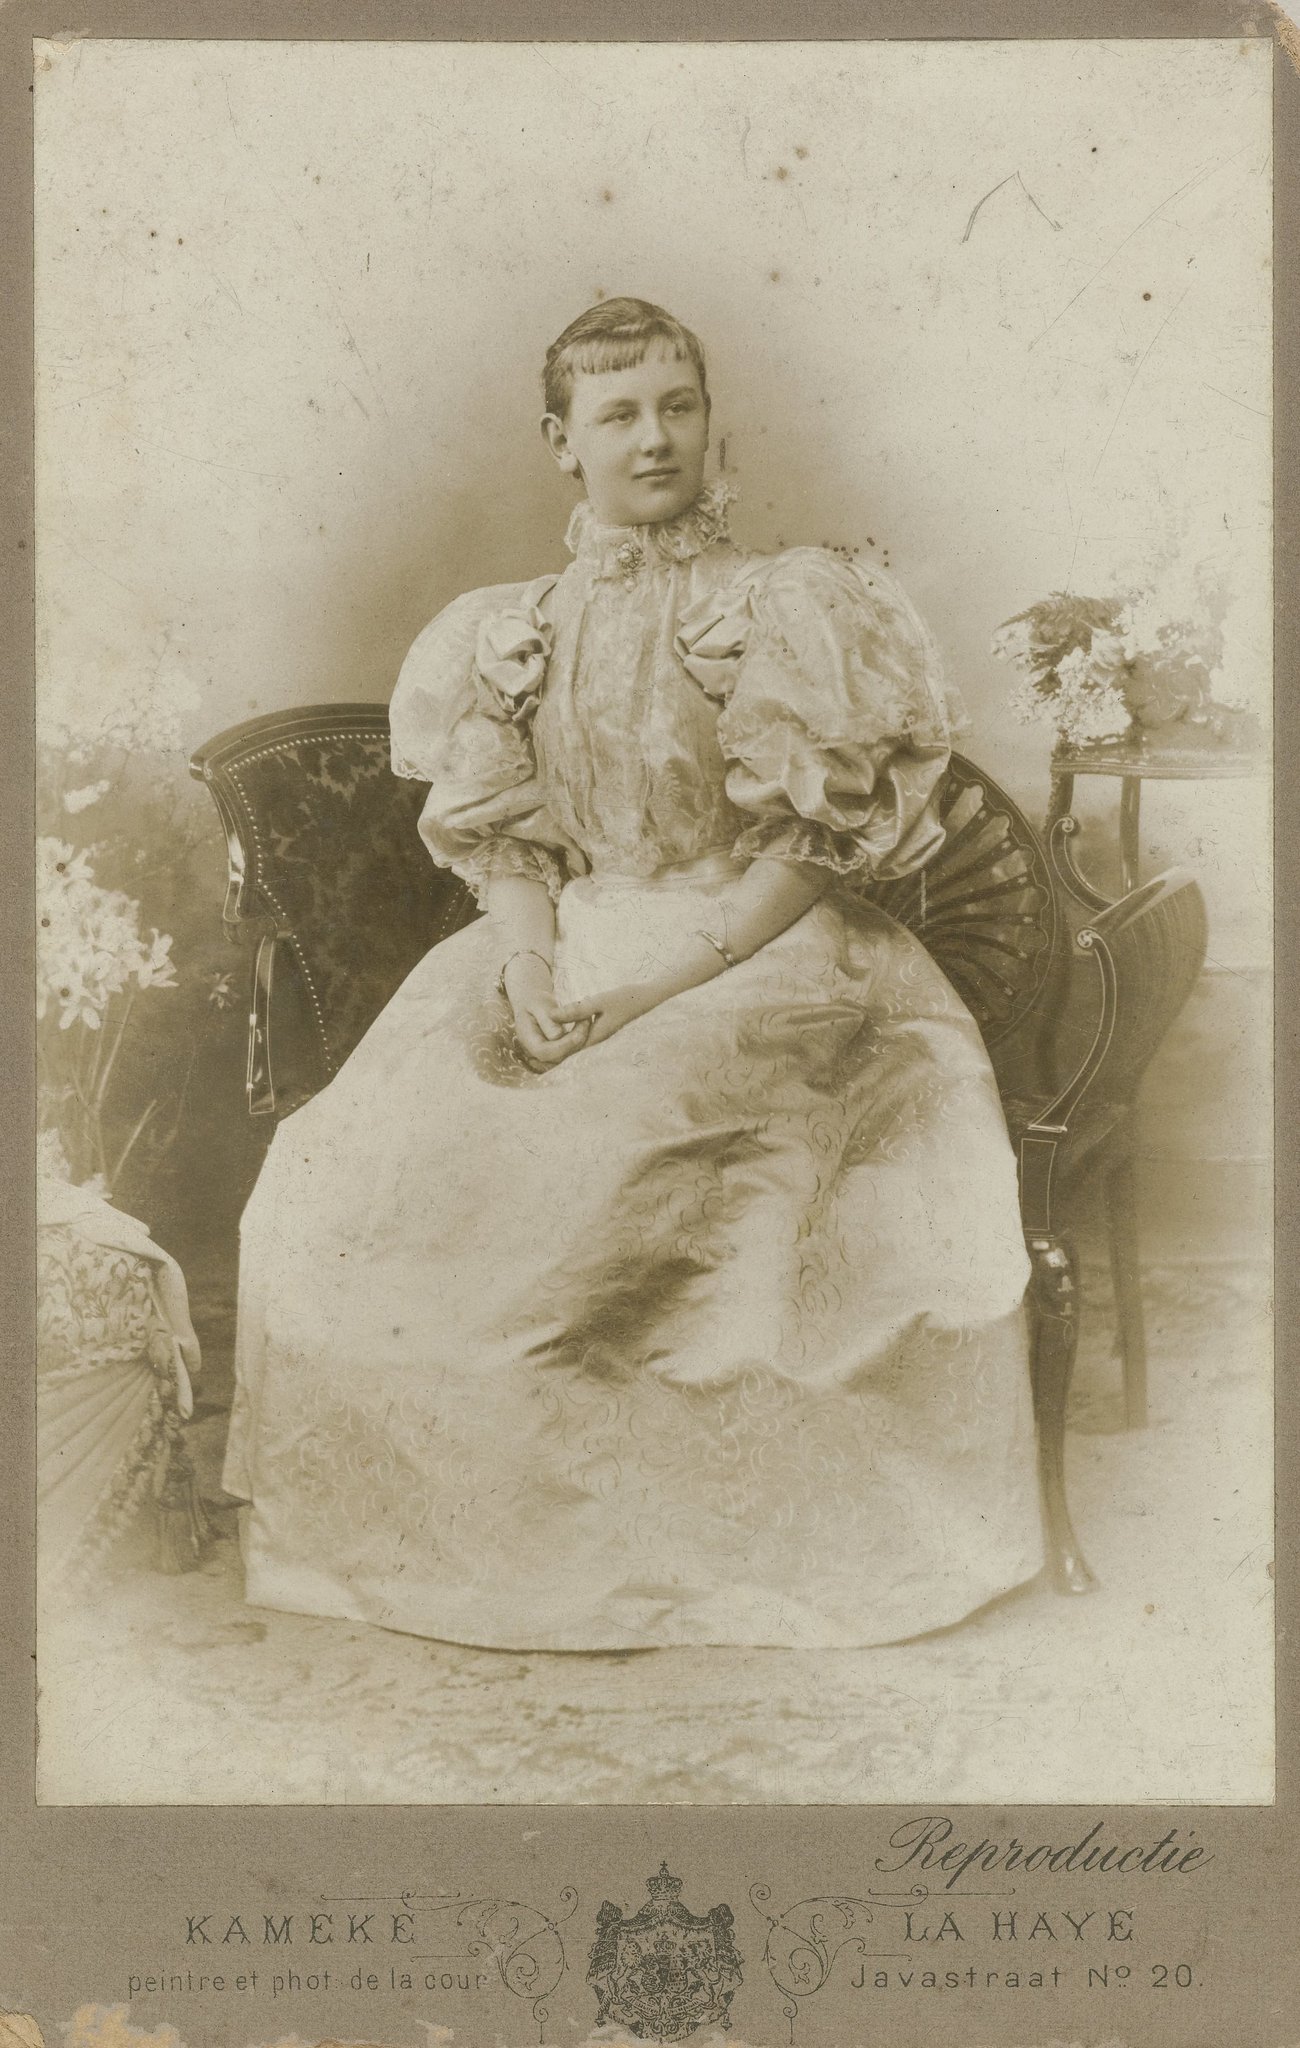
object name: photograph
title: Wilhelmina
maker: kameke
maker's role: painter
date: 1896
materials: cardboard, paper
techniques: photography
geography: the hague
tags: the hague, print maker, wilhelmina of the netherlands, netherlands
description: Koningin Wilhelmina op jeugdige leeftijd, zij zit op een canapé. Foto op karton.